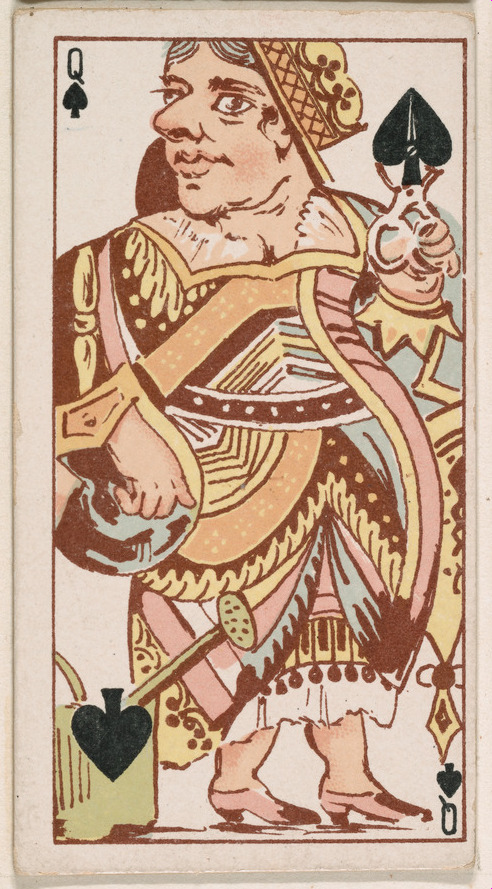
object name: print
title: Queen of Spades, The German, from Harlequin Cards, 2nd Series (N220) issued by Kinney Bros.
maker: kinney brothers tobacco company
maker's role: publisher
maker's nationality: american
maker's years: 1869-2011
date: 1889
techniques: color lithograph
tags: playing cards